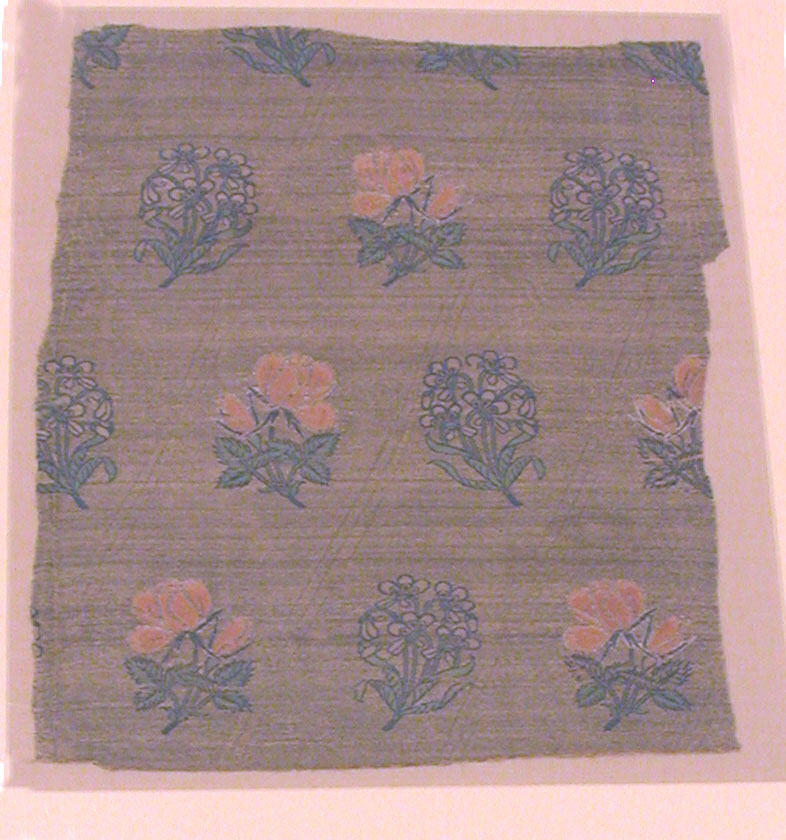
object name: textile fragment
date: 1501-1700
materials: metal thread, silk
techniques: brocade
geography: iran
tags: flowers